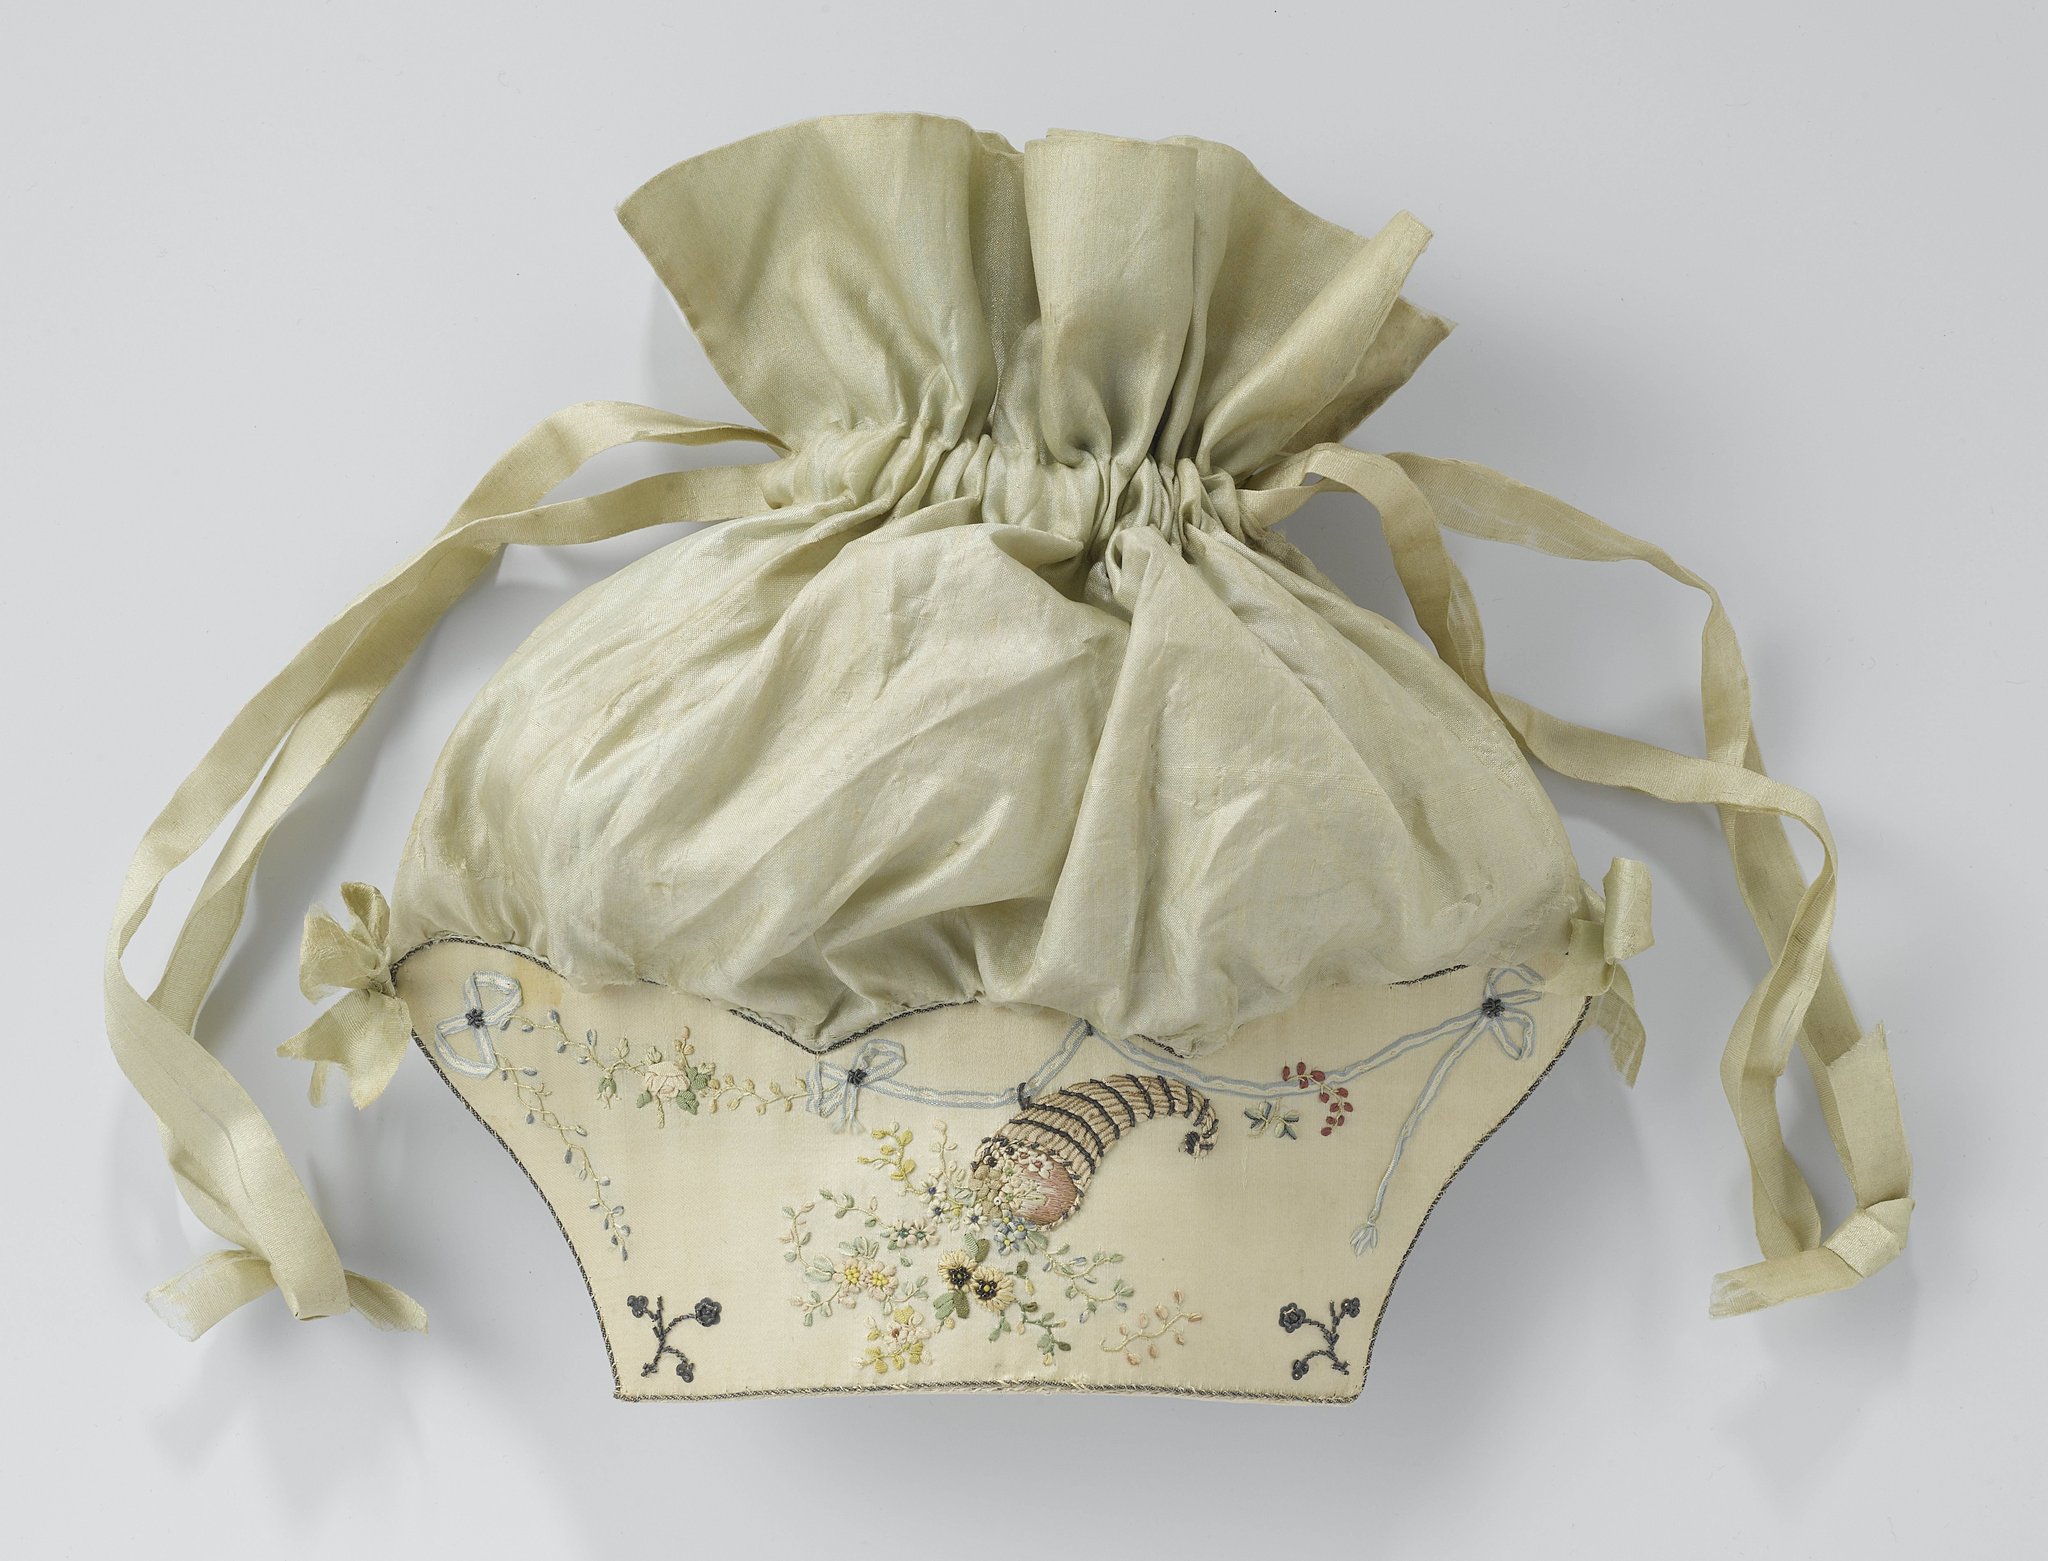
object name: purse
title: Reticule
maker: Anonymous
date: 1787-1807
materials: glass, paper, silk, silver, thread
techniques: weave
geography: netherlands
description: A similar bag from Paris was described in the German fashion magazine Journal des Luxus und der Moden of 1788 as ‘an elegant English lady’s work bag … mostly made of taffeta decorated with flowers’. Fashionable ladies carried their needlework in this type of drawstring purse, which was fitted with a thick paper box as the base. This model was replaced only around 1807 with elongated fabric bags with drawstrings.